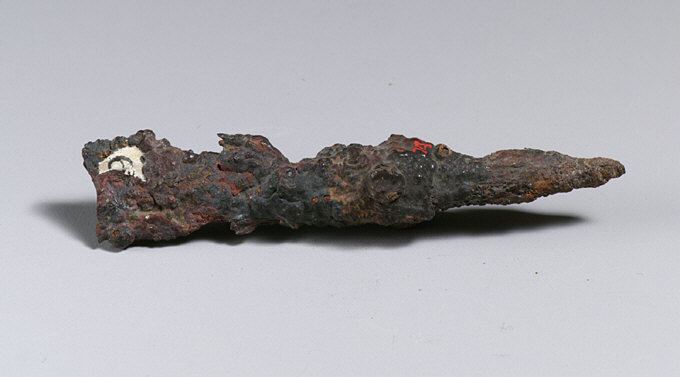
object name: arrowhead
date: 7000 BCE-330 CE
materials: iron